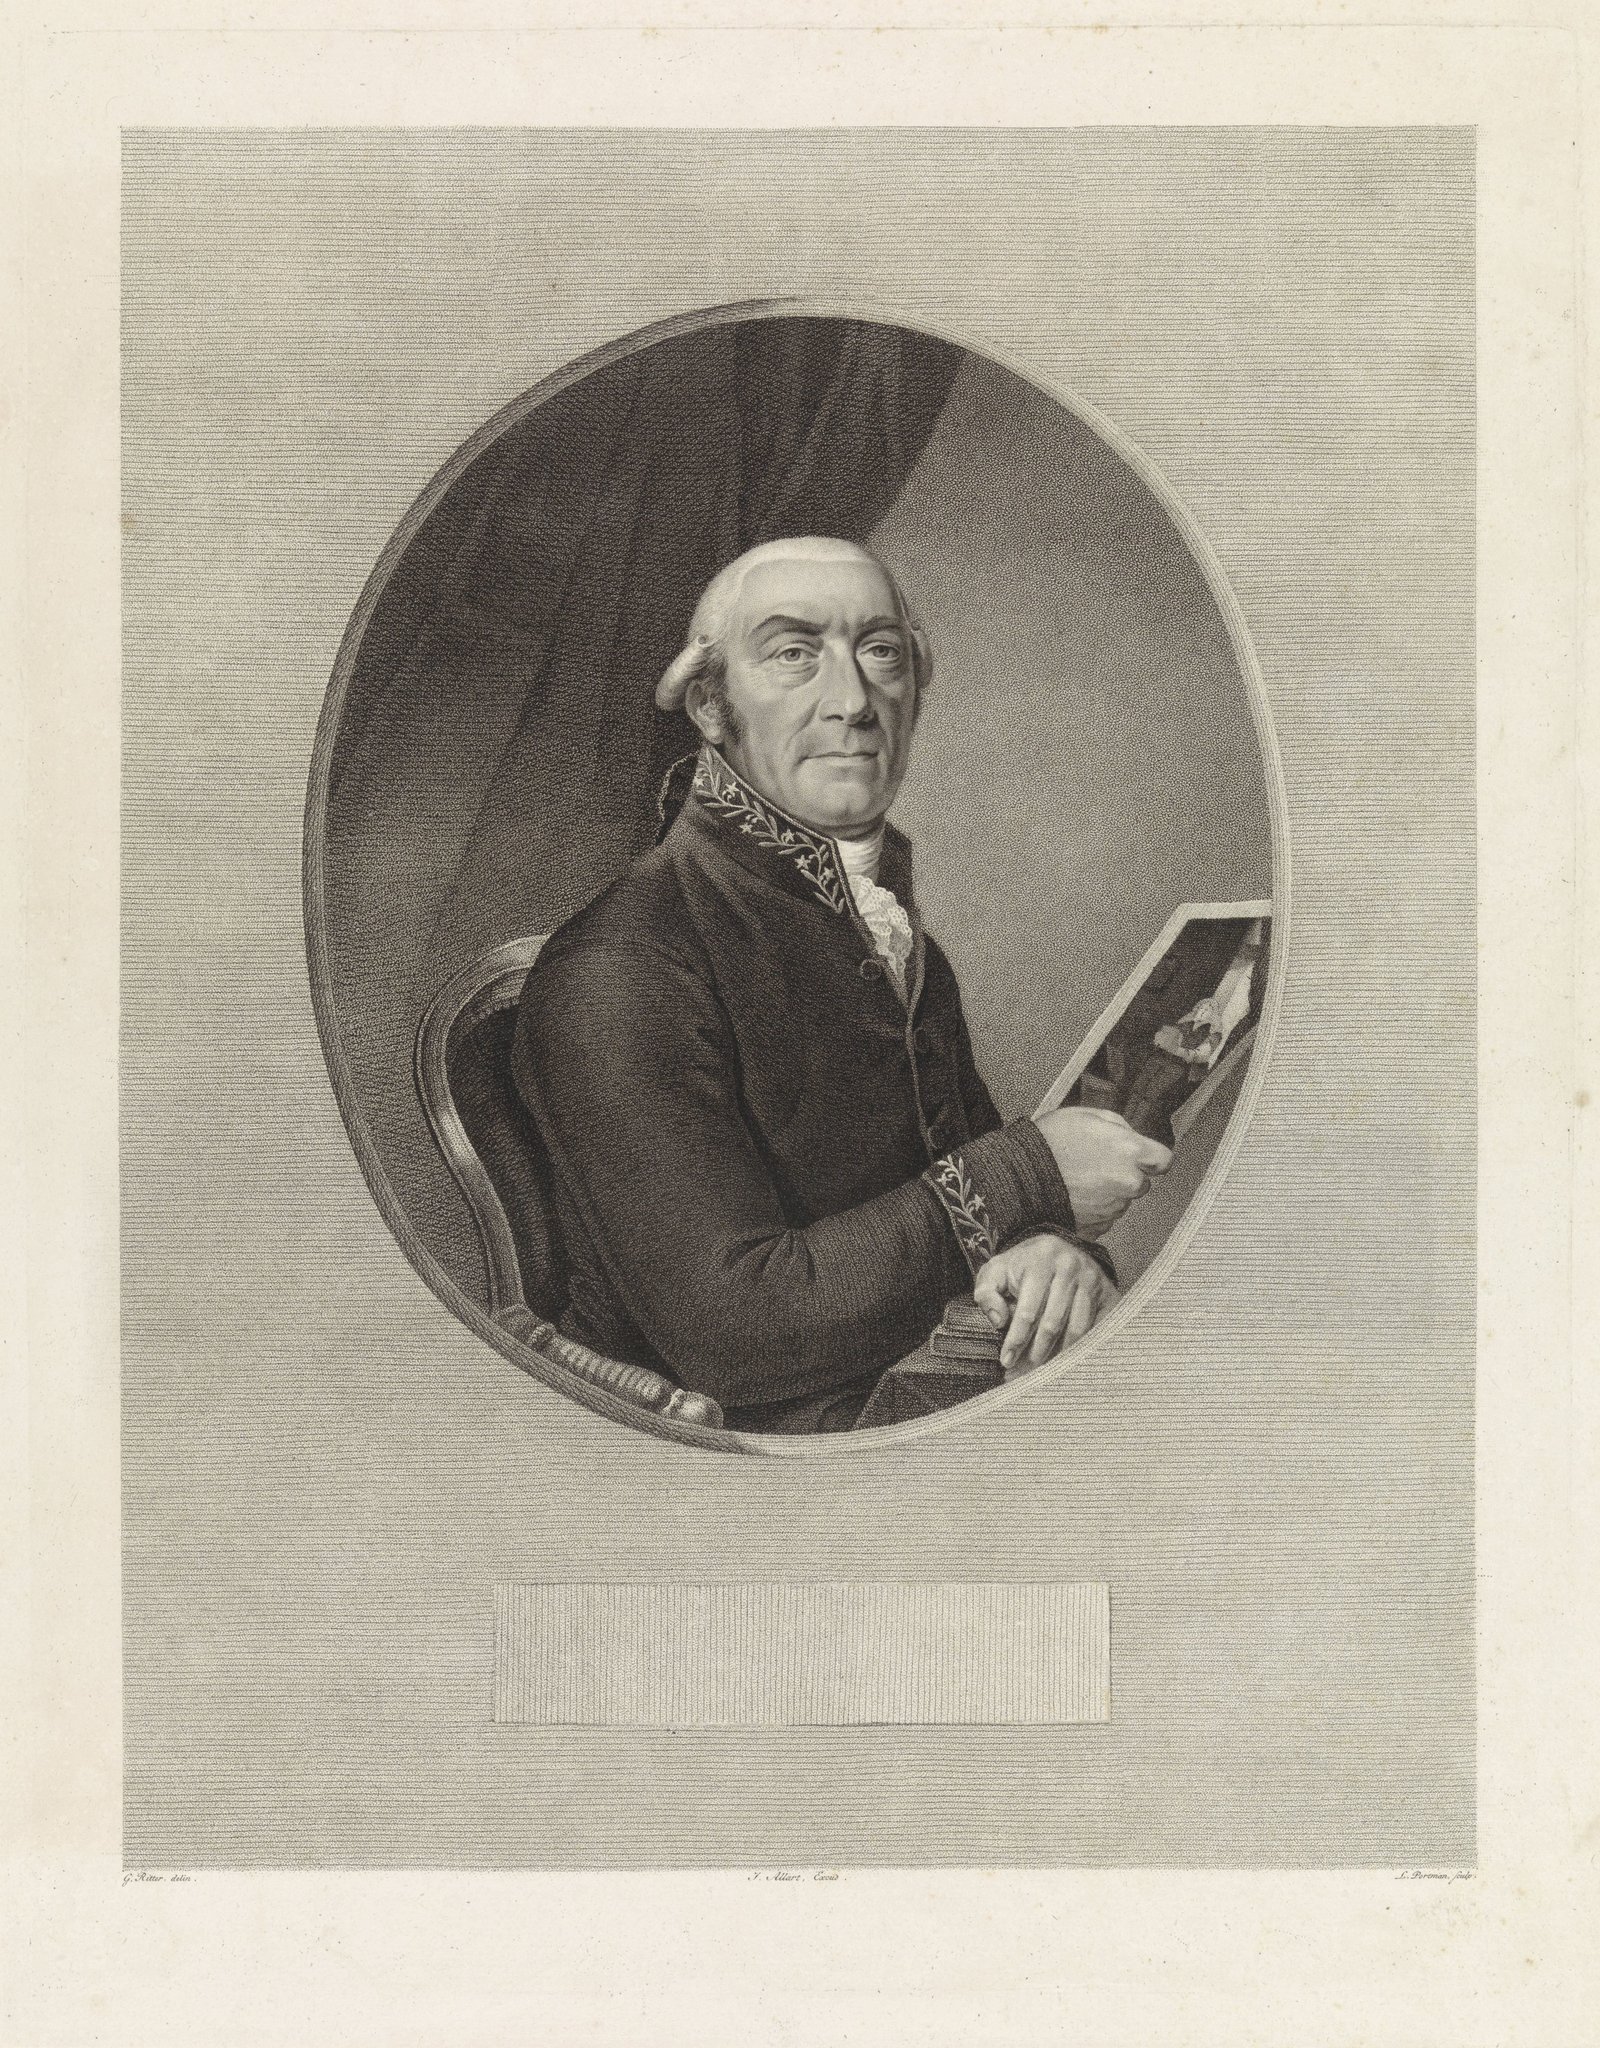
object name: print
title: Portret van Cornelius Henricus à Roy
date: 1794-1828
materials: paper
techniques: etching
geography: amsterdam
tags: print, e.g.: engraving, etching, lithograph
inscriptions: collector's mark: Lugt 2228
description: Portret van Cornelius Henricus à Roy, lijfarts van Lodewijk Napoleon. In zijn rechterhand houdt hij een afdruk van de ets met het portret van Jan Six door Rembrandt.